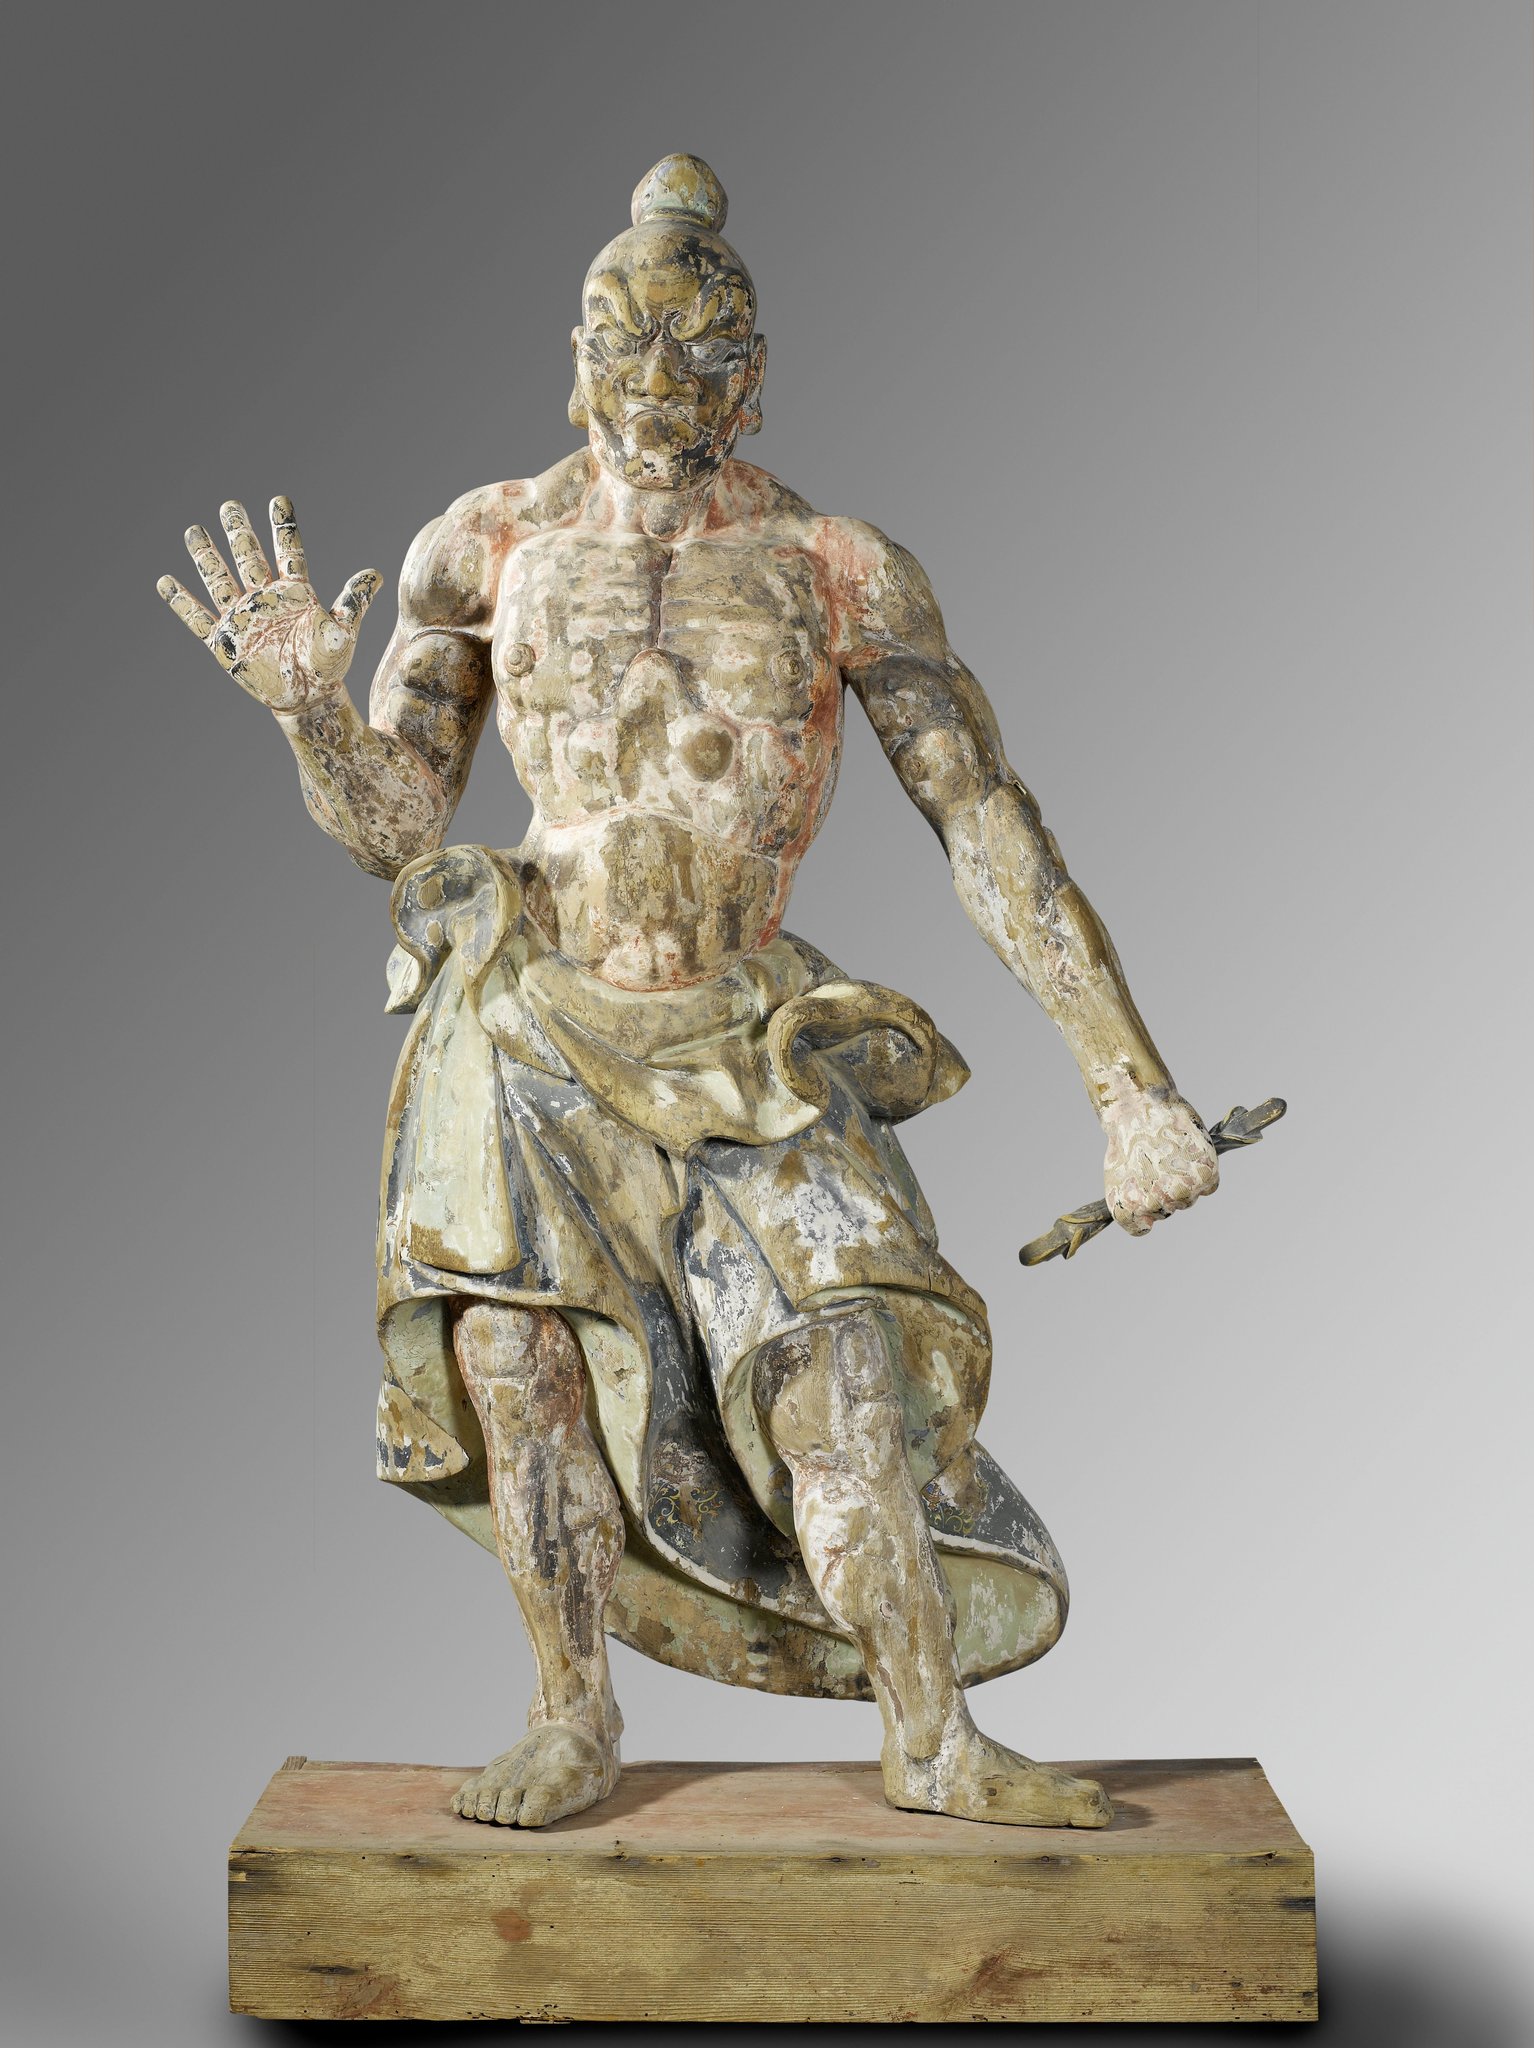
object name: sculpture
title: Temple guardian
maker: Anonymous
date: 1300-1400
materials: wood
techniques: polychromy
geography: japan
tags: temple watch ~ non-christian religions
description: De tempelwachters (AK-RAK-2007-1-A/B) stonden bij de ingang van de tempel Iwayaji in de West-Japanse prefectuur Shimane.